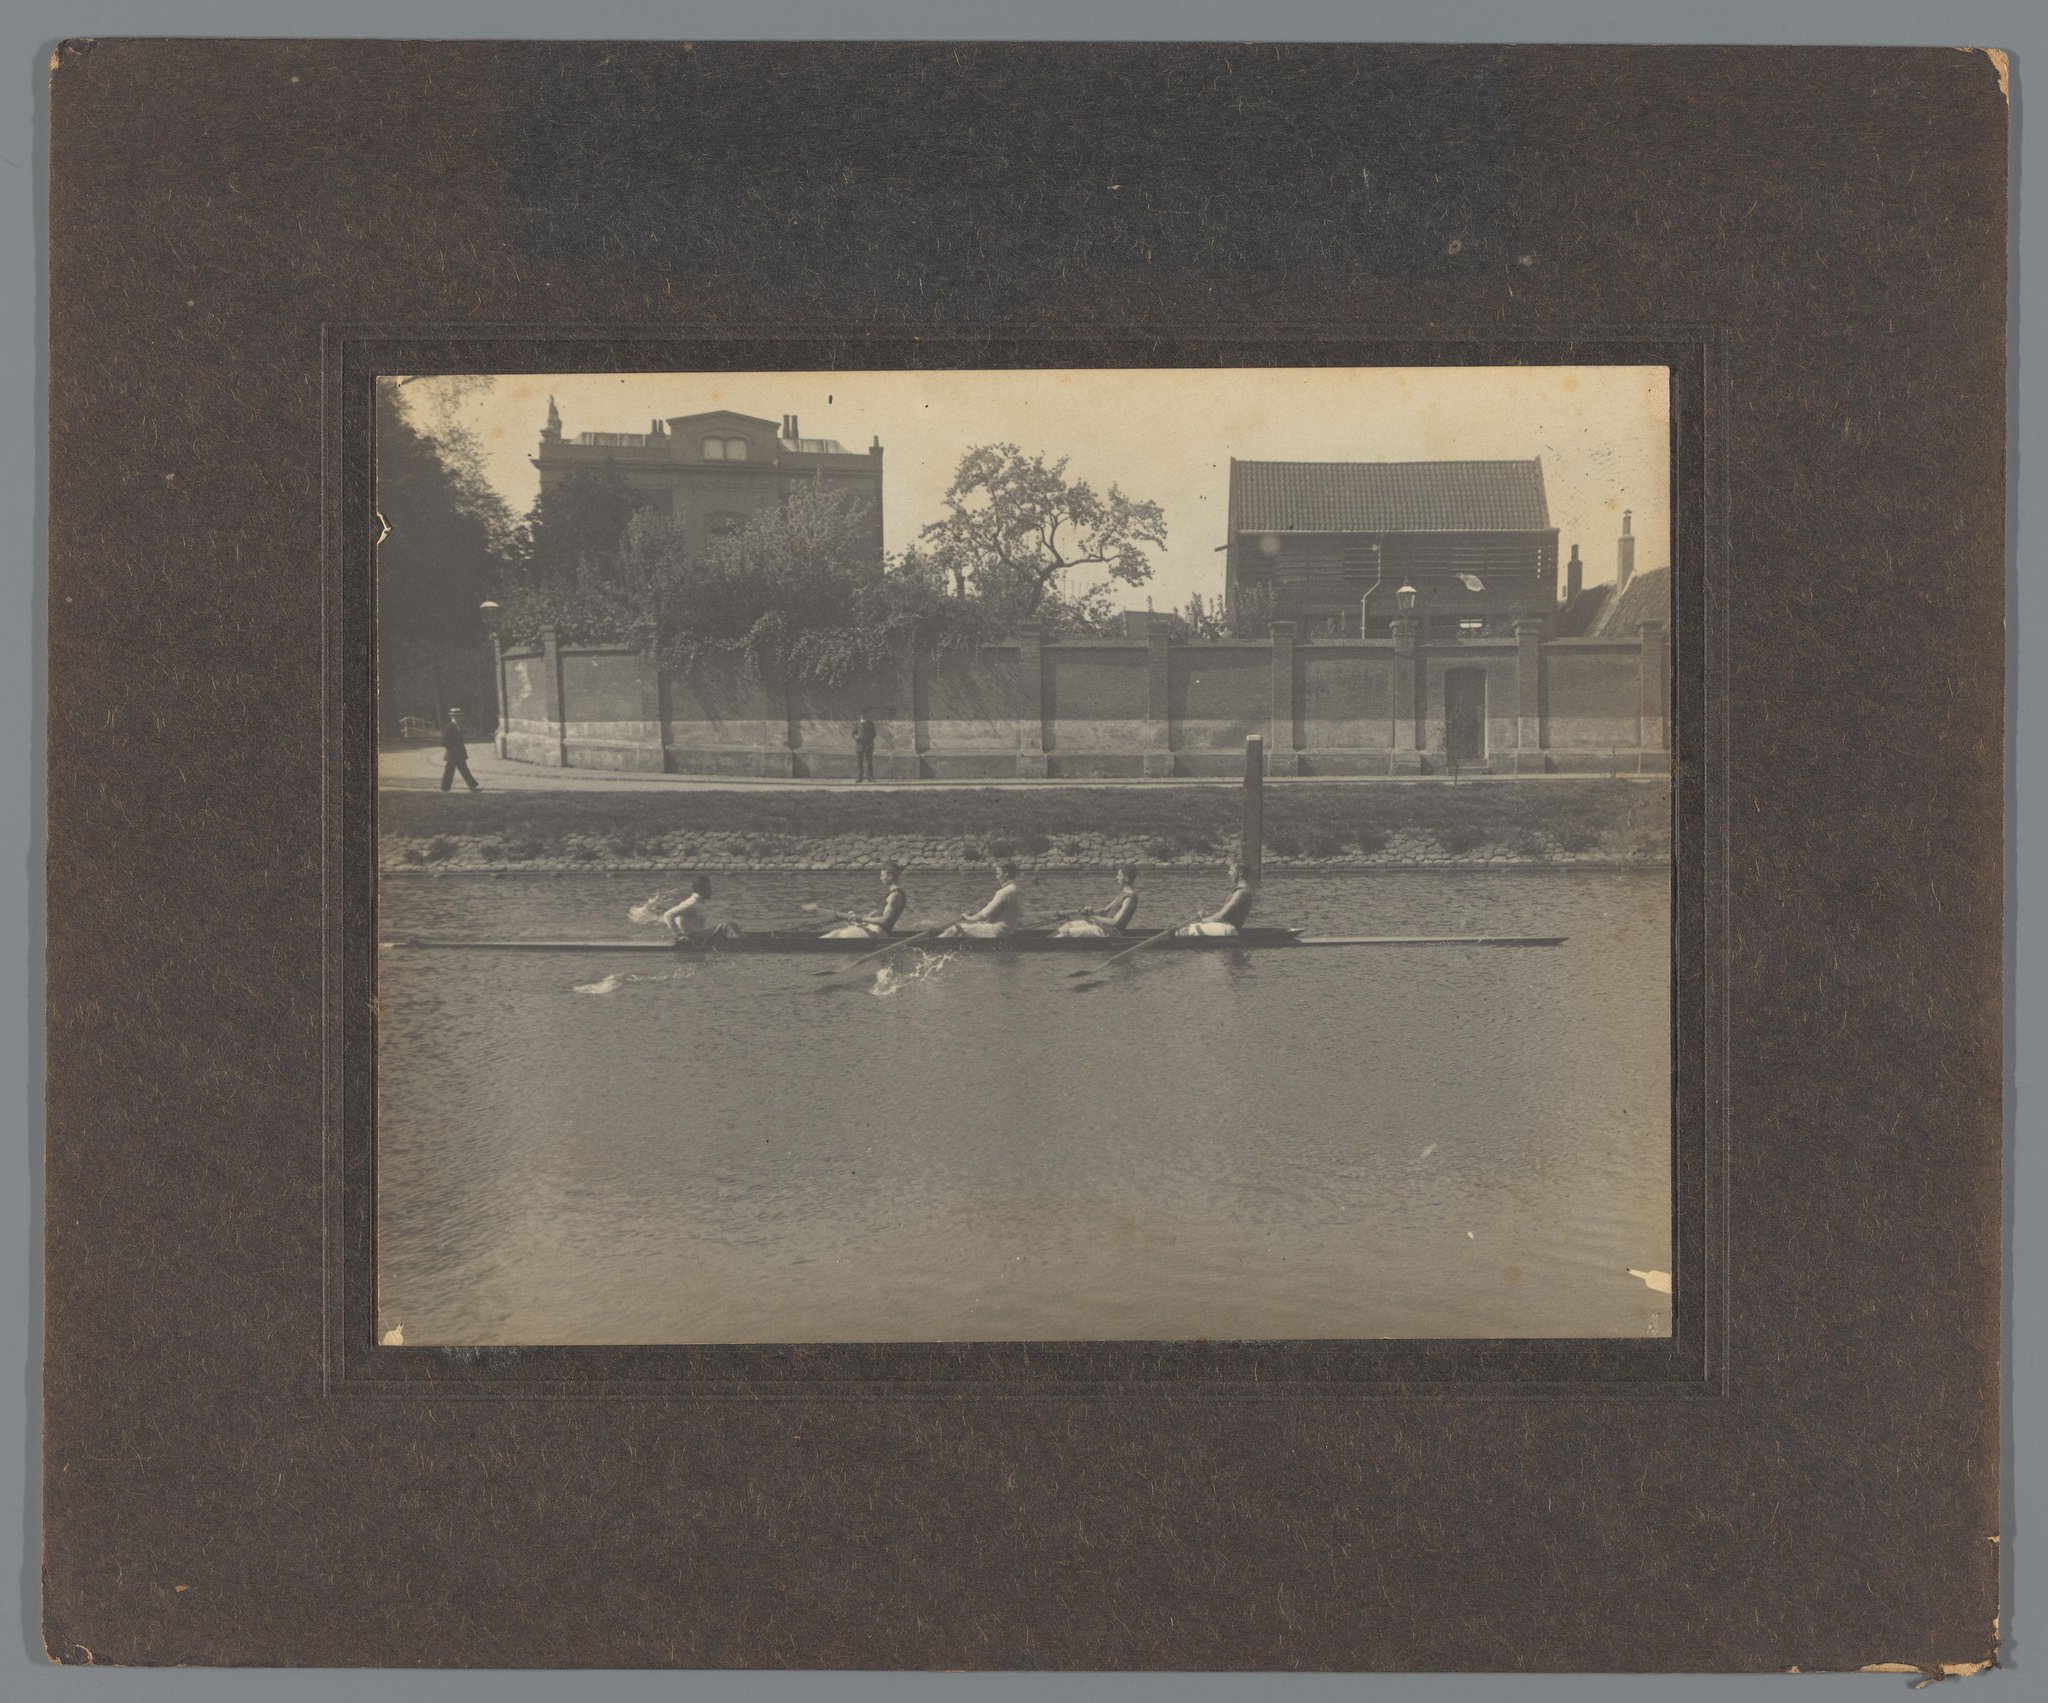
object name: photograph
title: Jonge Vier in actie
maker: Anonymous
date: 1915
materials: paper, cardboard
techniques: gelatin silver print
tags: rowing facing backward, pulling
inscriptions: inscription: ‘Jonge vier 1915./ N. Guldenaar (stuur)/ L.L.C. Polis (slag)/ A.H. van Assen./ A.H. Mijnlieff/ J. Jongejan (boeg)’